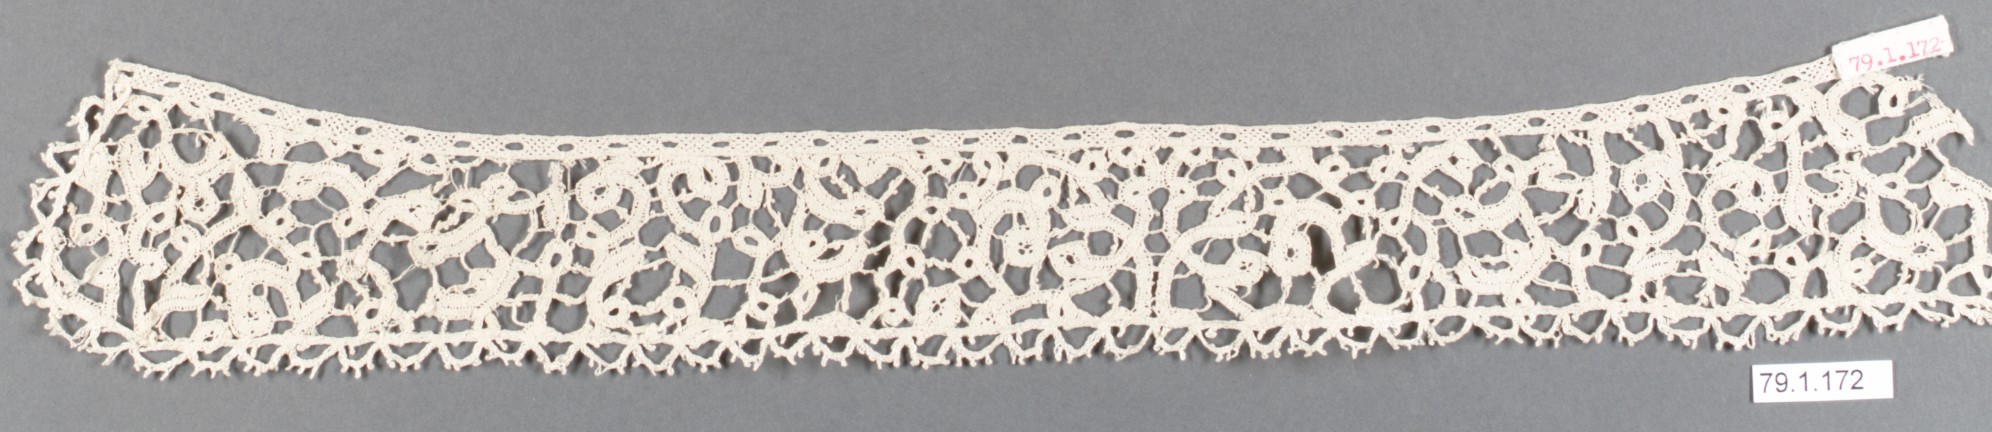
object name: strip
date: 1667-1700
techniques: lace